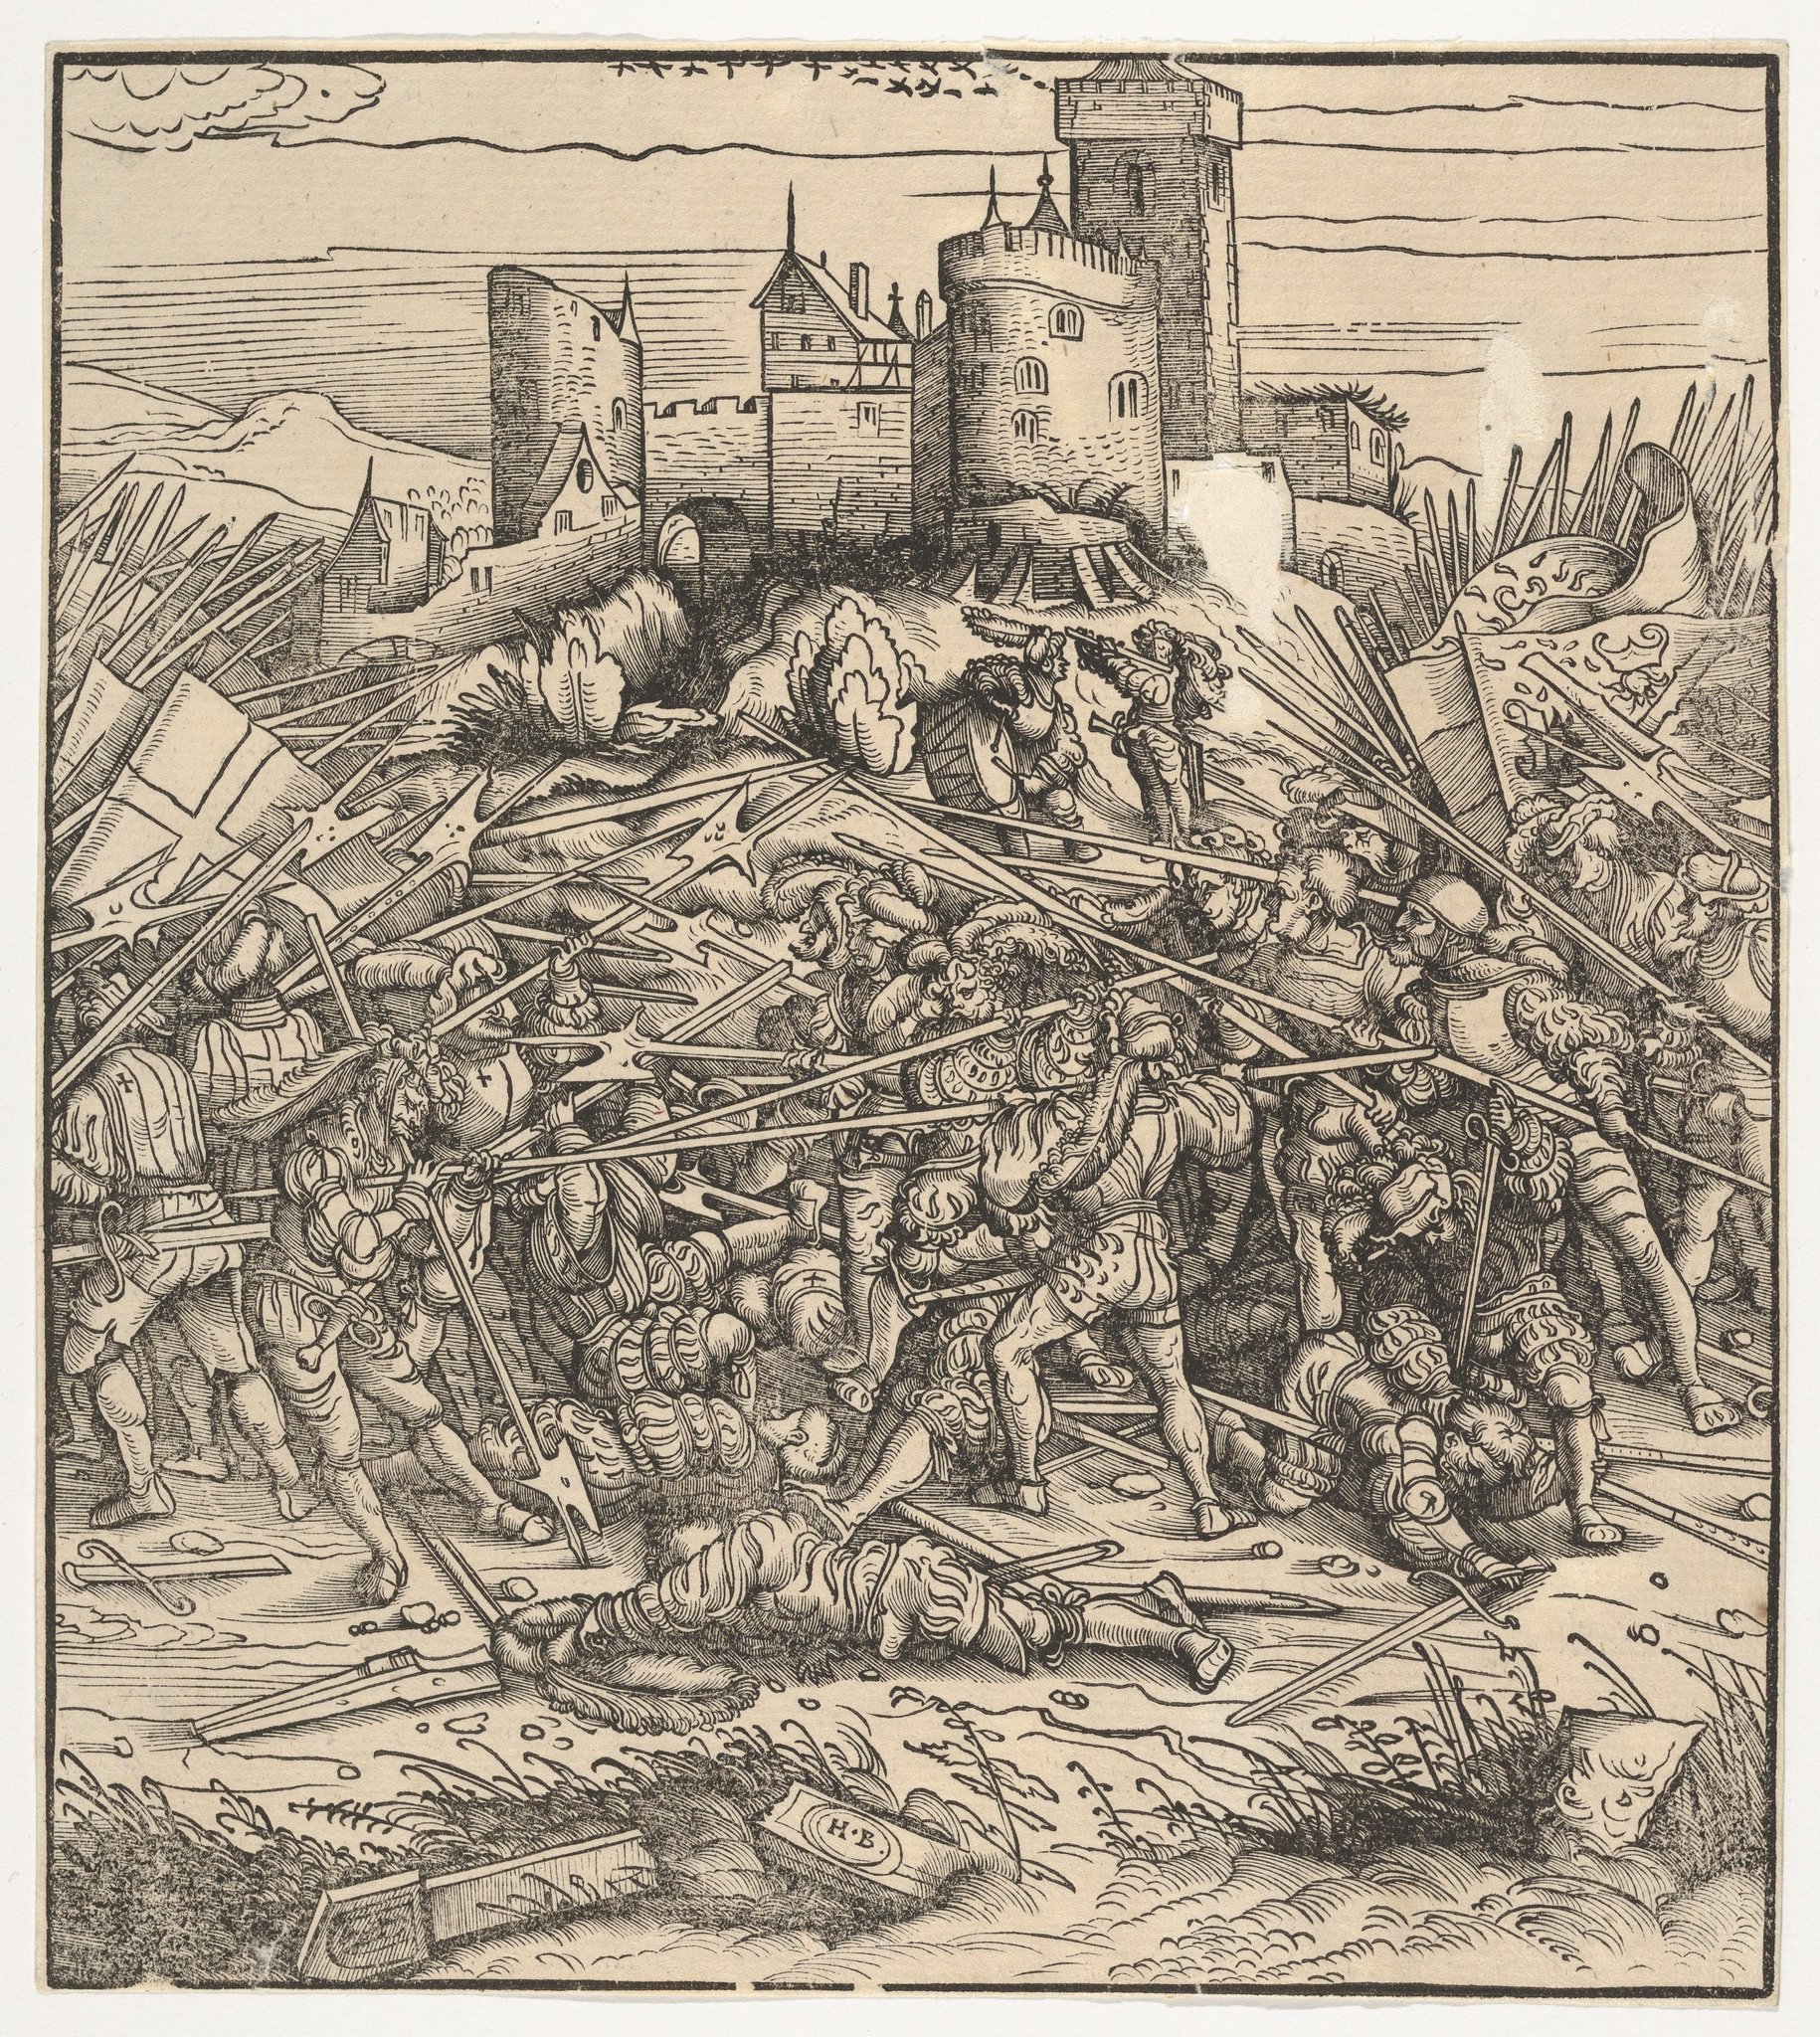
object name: print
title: The Battle Near Naples, from "Der Weisskunig"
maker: hans burgkmair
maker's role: artist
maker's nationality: german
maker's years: 1473-1531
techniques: woodcut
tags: battles,soldiers